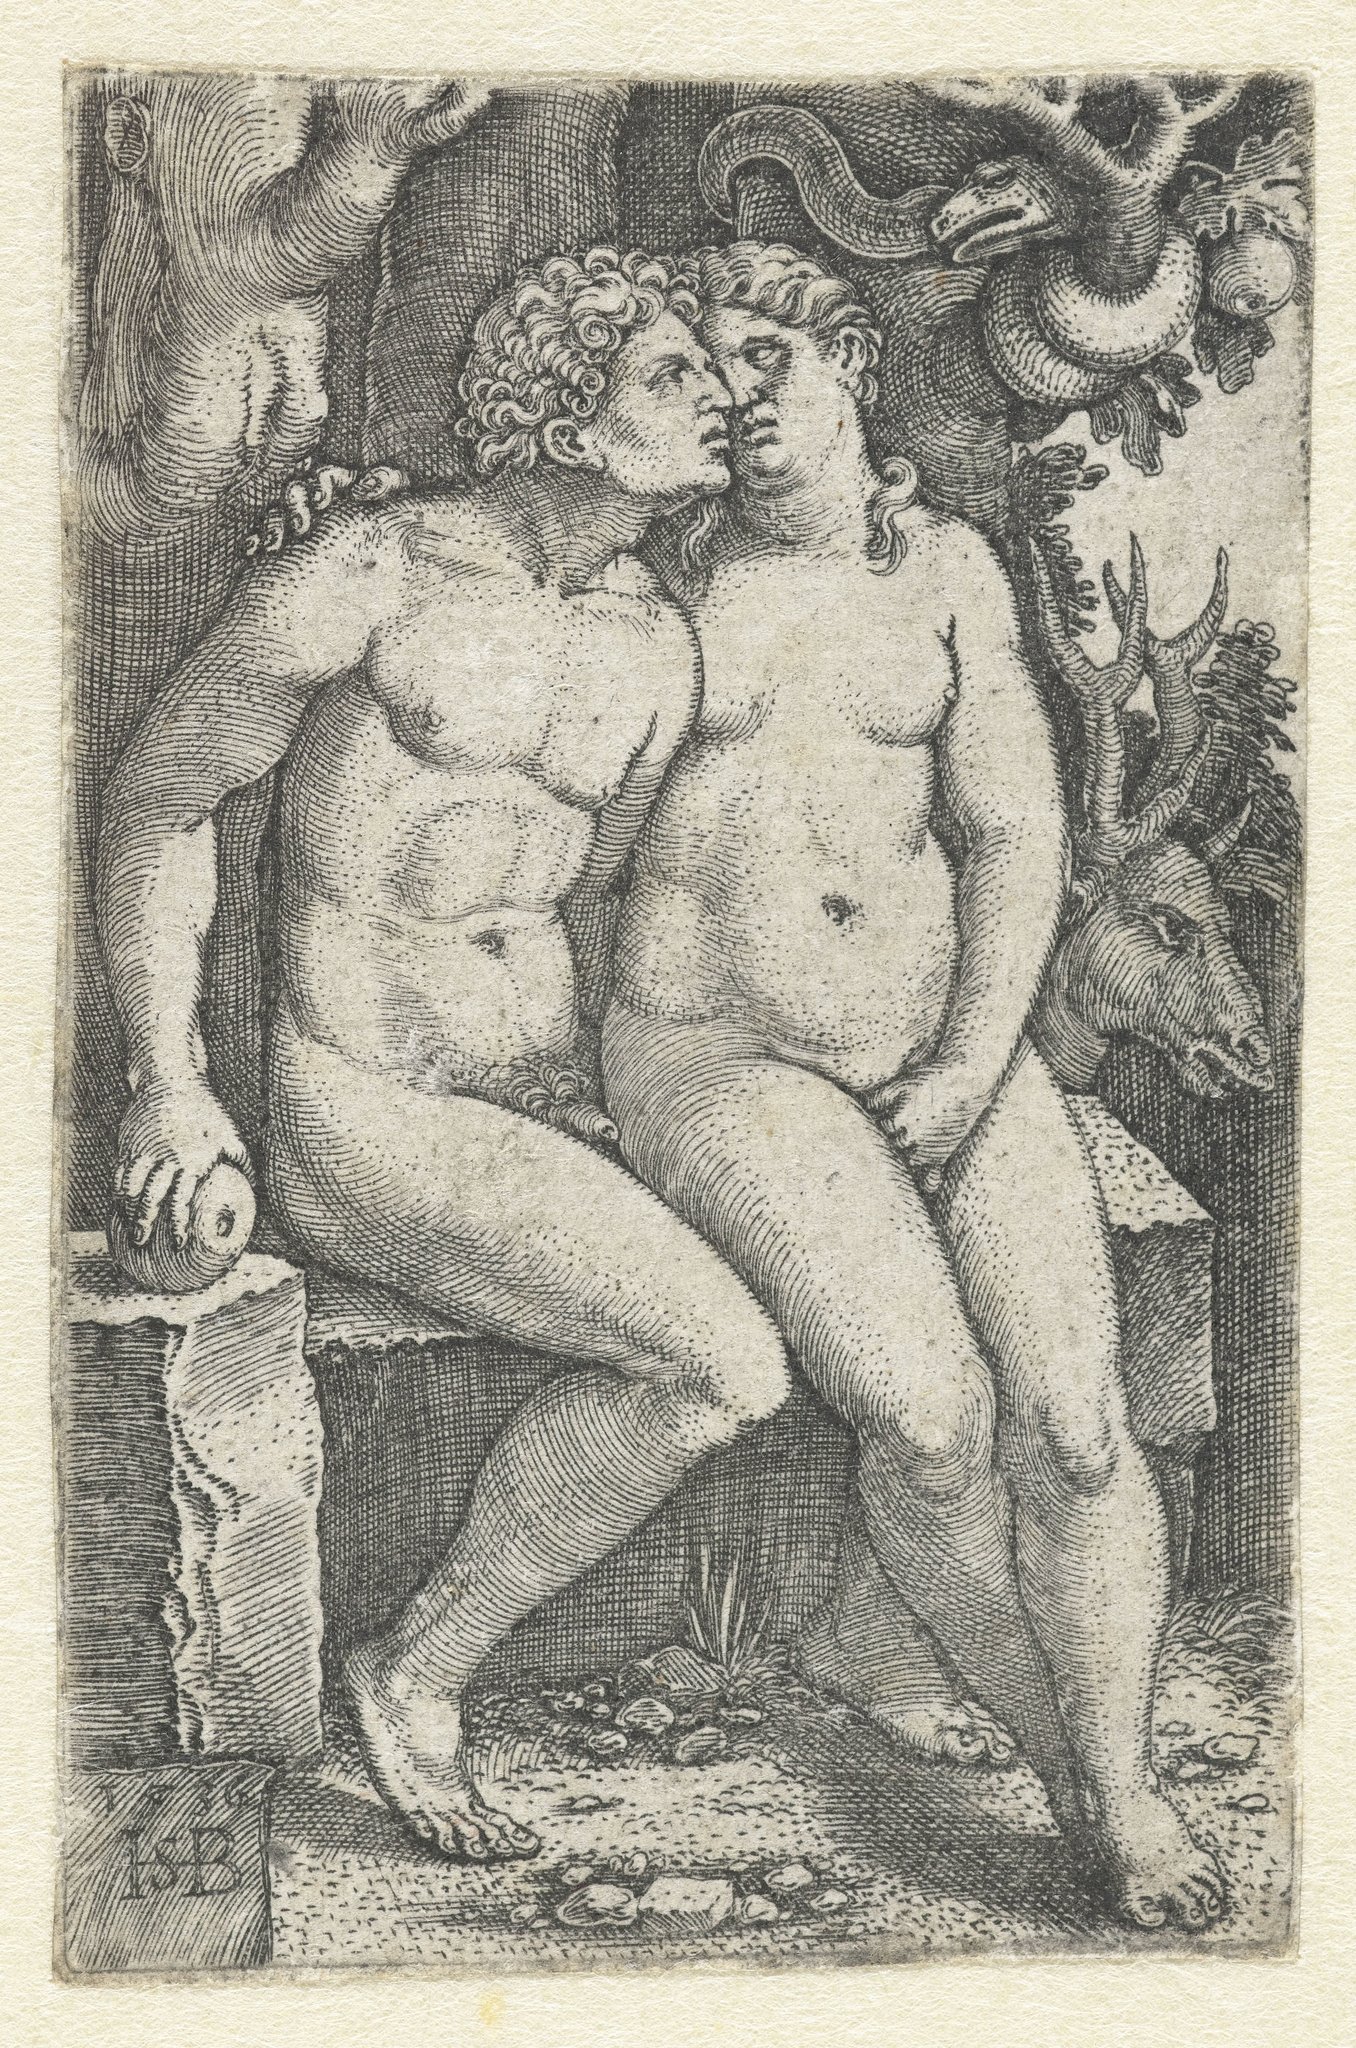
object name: print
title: Verzoeking van Adam en Eva in het paradijs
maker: hans sebald beham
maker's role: designer, draughtsman, print maker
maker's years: 1500-1550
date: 1536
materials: paper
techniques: engraving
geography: frankfurt am main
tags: temptation and fall (scenes with both adam and eve)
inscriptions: collector's mark: Lugt 2228a